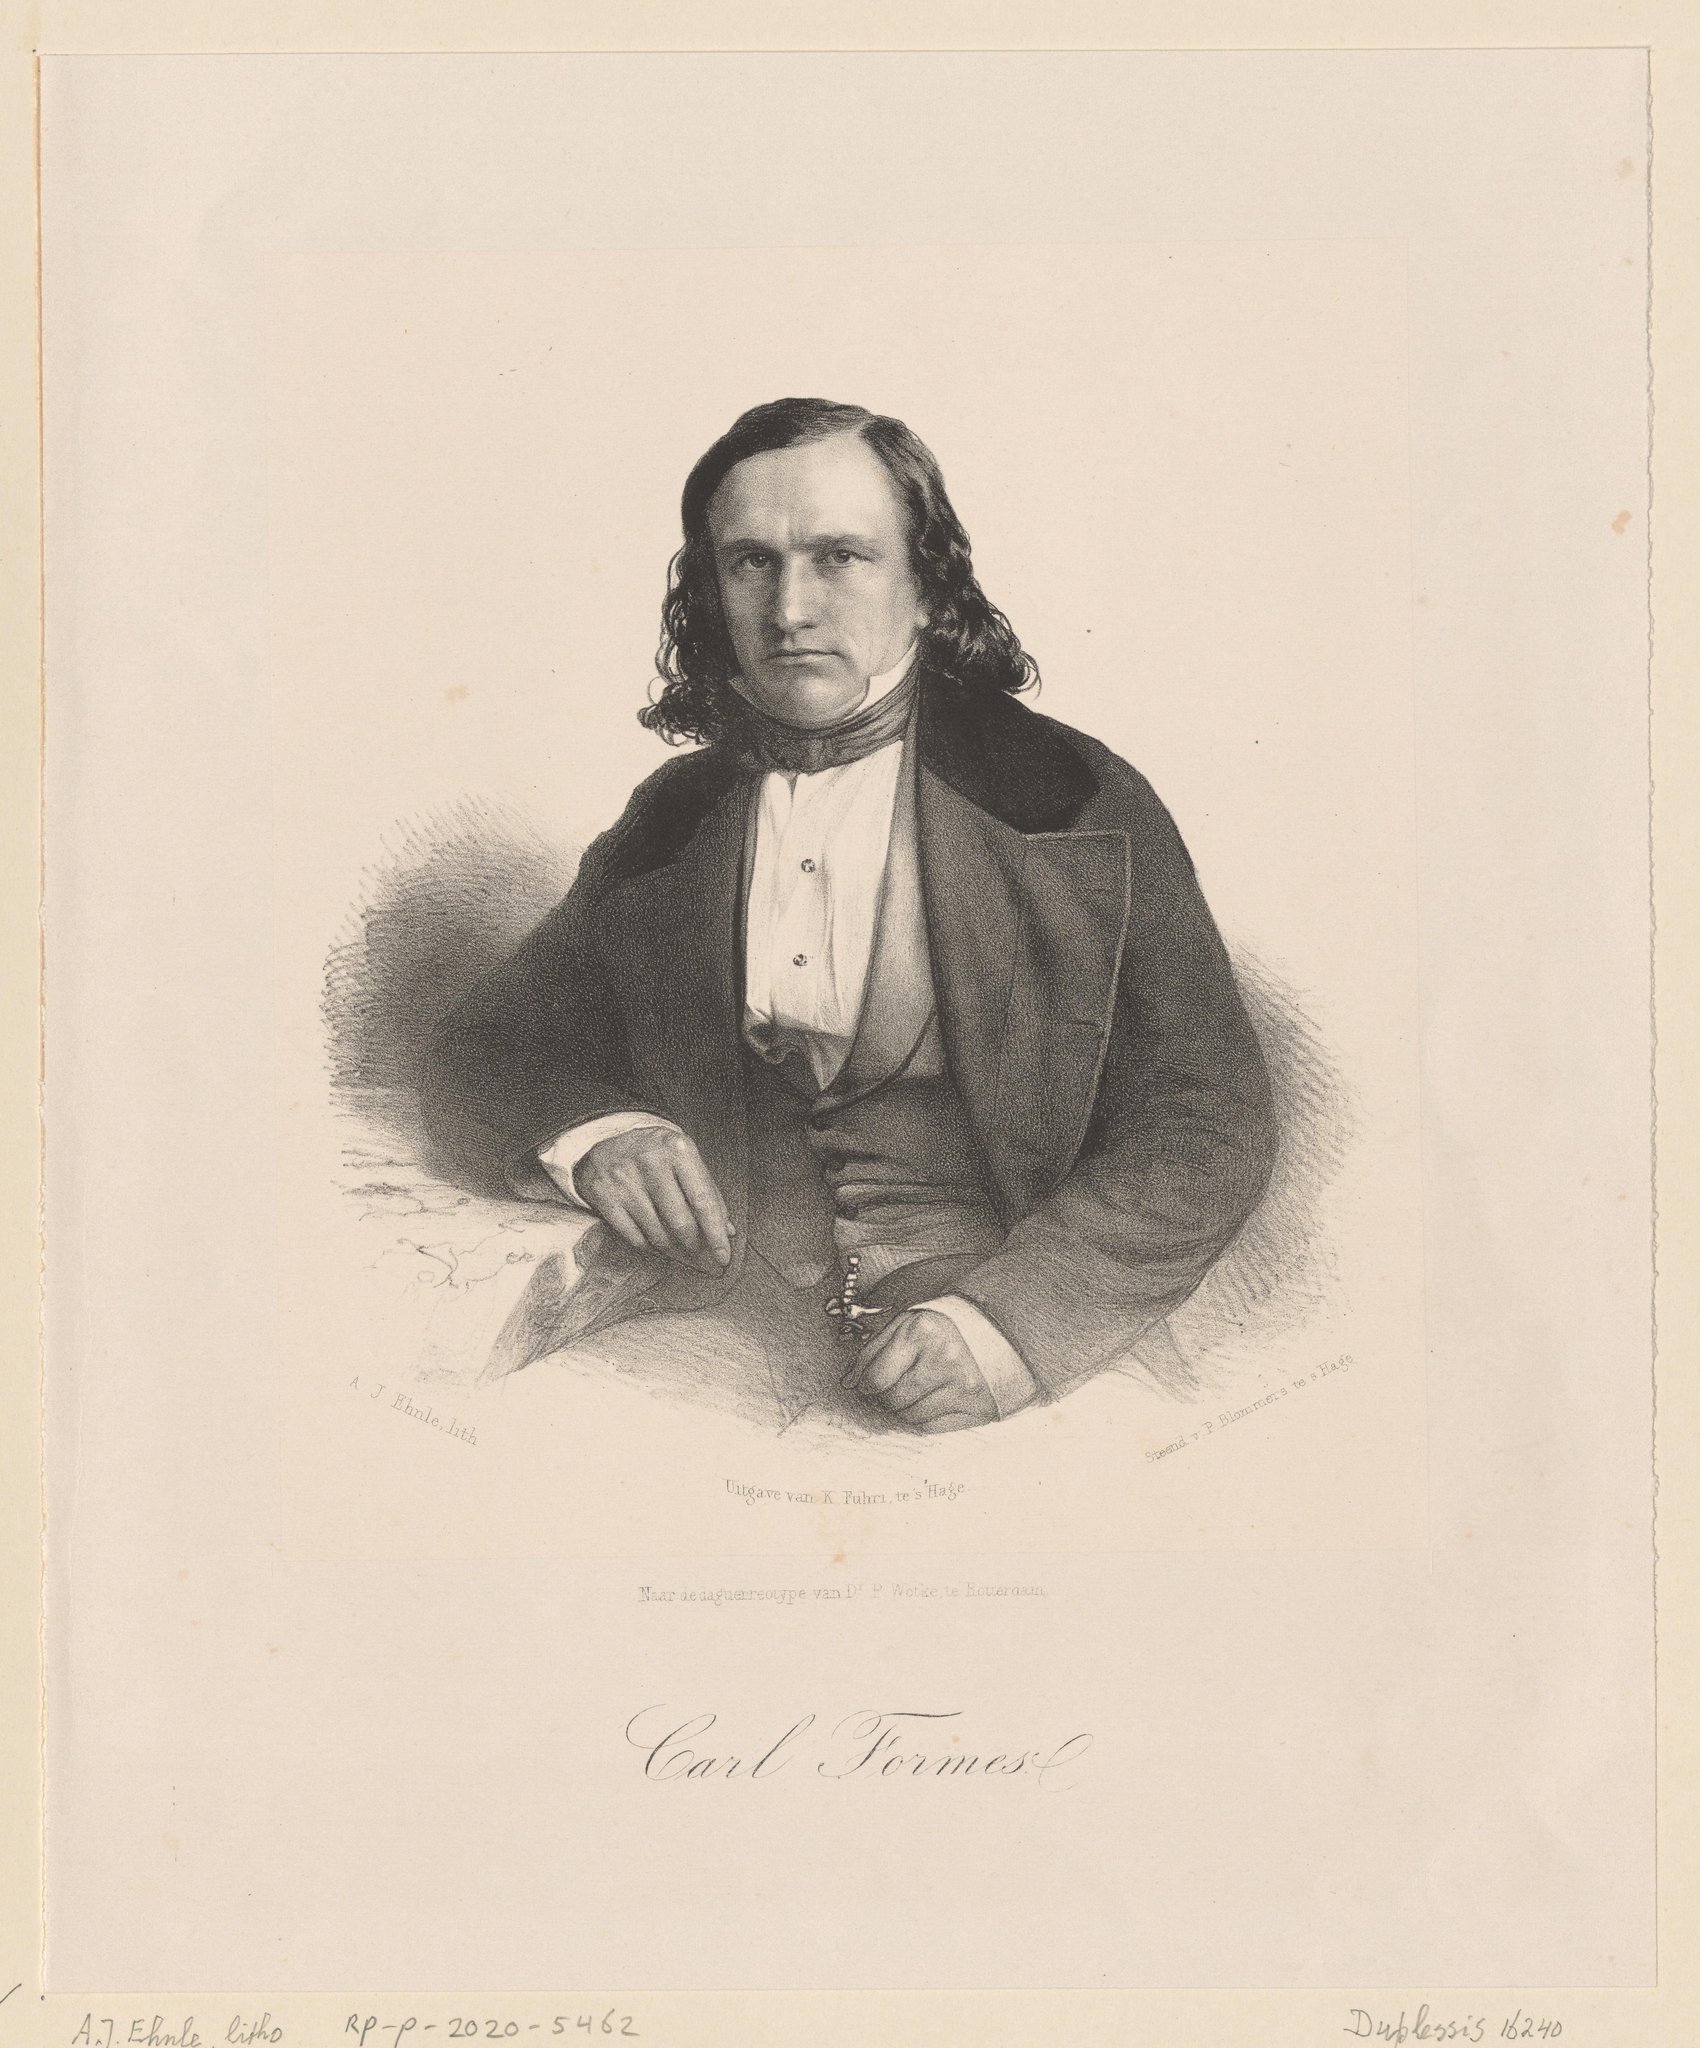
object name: print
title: De Maatschappij ter Bevordering van Toonkunst, haar Muziekfeest en de stad Rotterdam. Herinnering aan het jaar 1854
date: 1855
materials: paper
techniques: lithograph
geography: the hague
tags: historical persons, portrait of opera-singer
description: Onderdeel van een serie van twaalf portretten naar daguerreotypieën en twaalf stadsgezichten. Ter gelegenheid van het Muziekfeest ter viering van het 25-jarige bestaan van de Maatschappij ter Bevordering van Toonkunst in Rotterdam, 12-15 juli 1854.